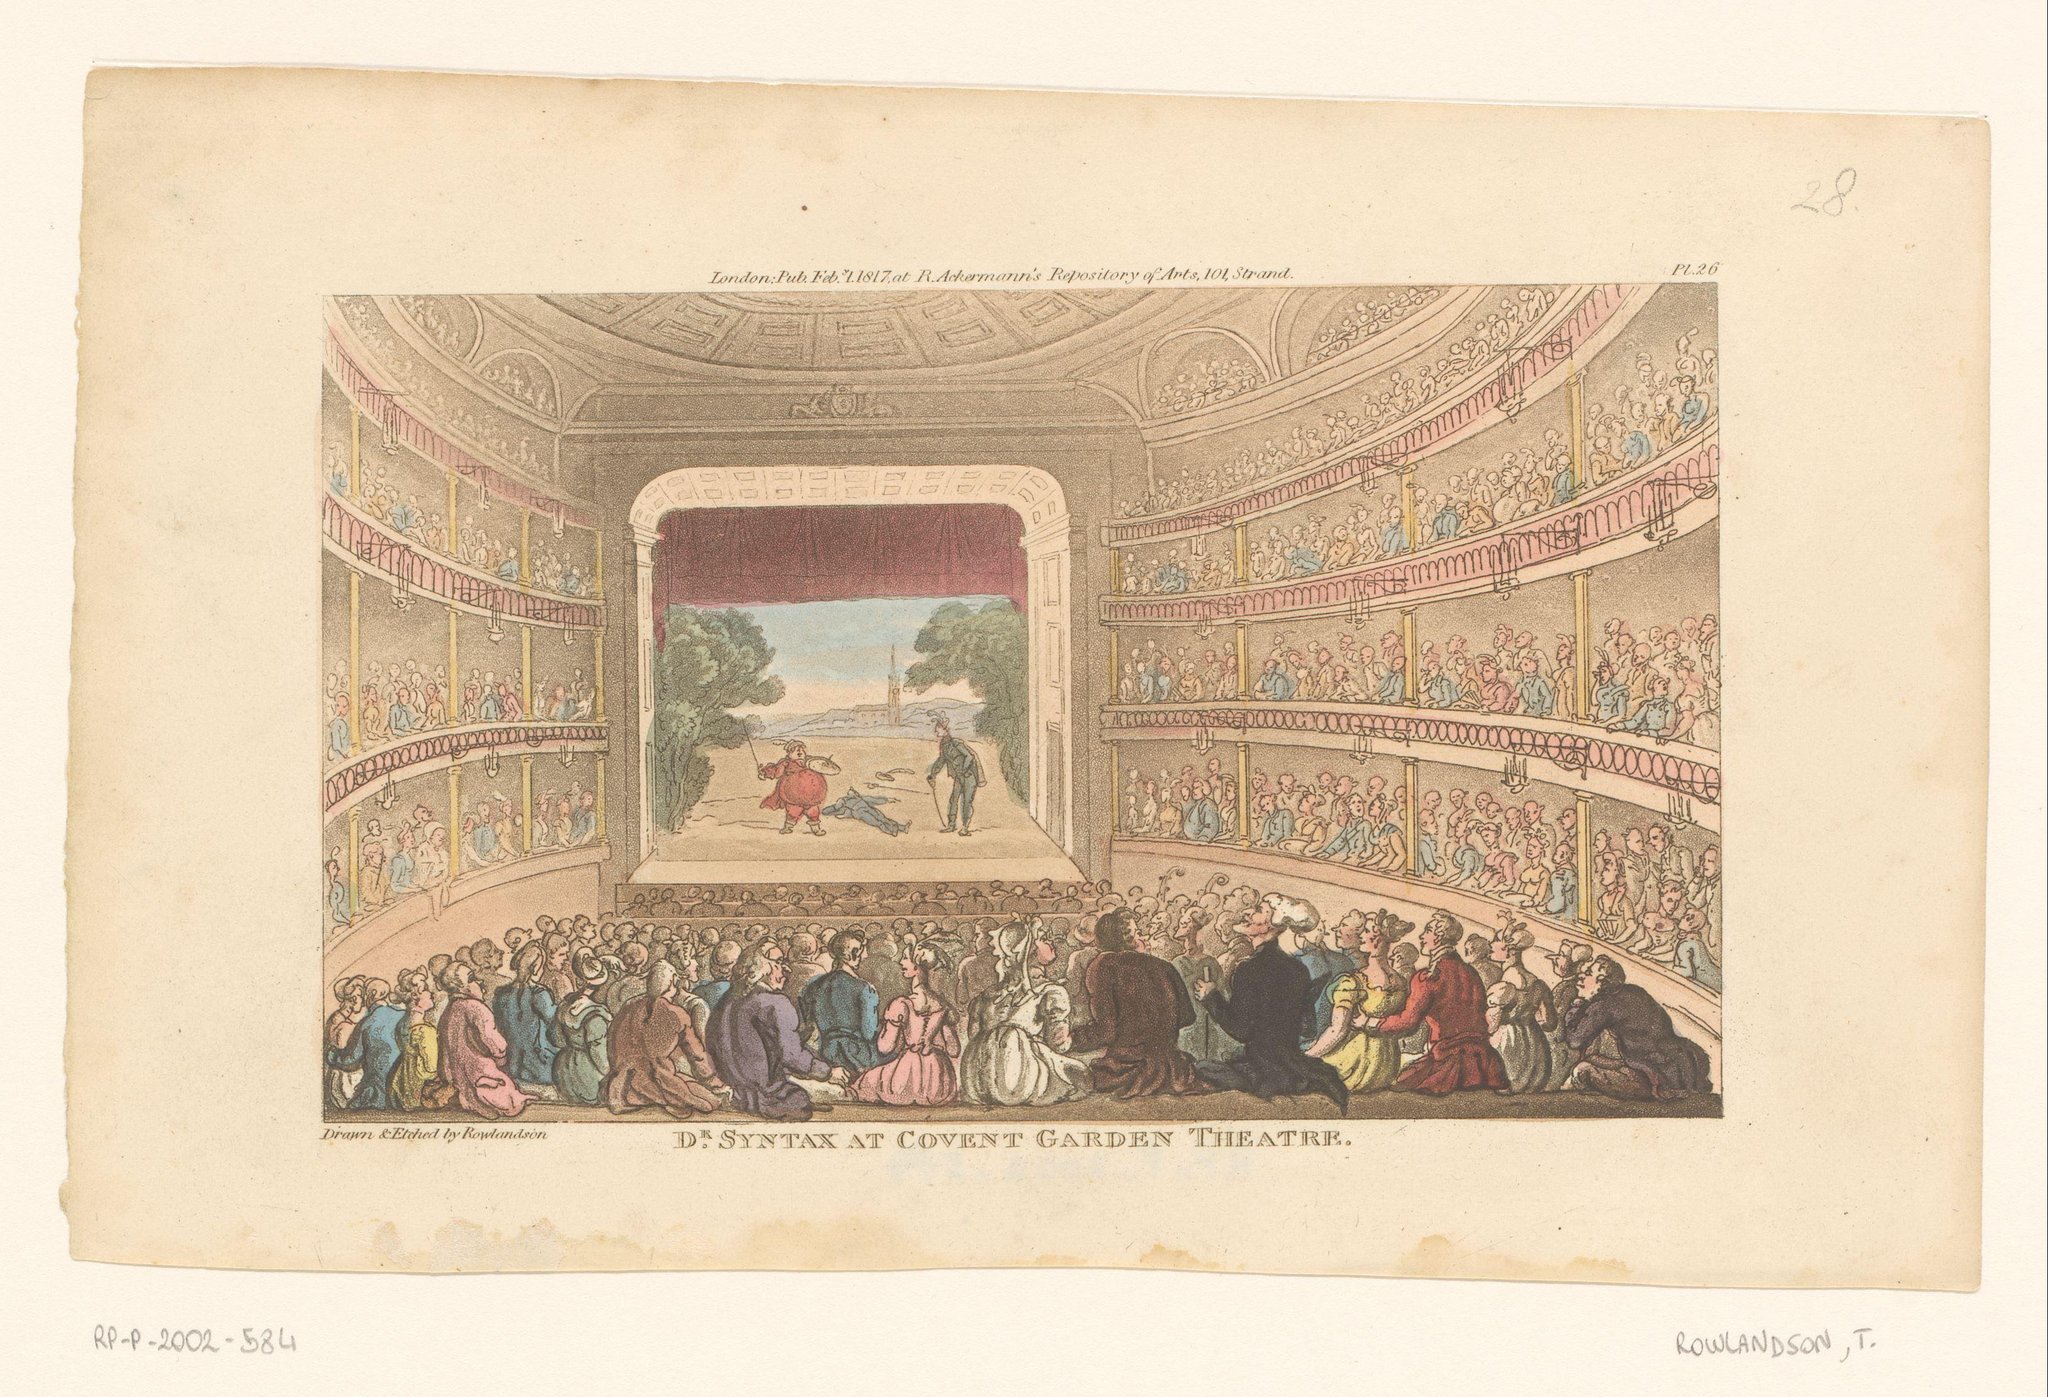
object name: print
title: Dr. Syntax at Covent Garden Theatre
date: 1802-1817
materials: paper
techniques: aquatint, etching, hand coloring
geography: london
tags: theatre, theatrical performance, theatre (building), the audience ~ art performance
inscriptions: collector's mark: Lugt 2228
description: Prent ook gebruikt in: Combe, William. The Tour of Doctor Syntax, in Search of the Picturesque. A Poem. Londen: Rudolph Ackermann, 1819. Het gedicht is een satire op William Gilpin, die in Groot-Brittannië op zoek ging naar 'het pittoreske'. Het gedicht verscheen voor het eerst met illustraties van Rowlandson in The Poetical Magazine, tussen 1809 en 1811. Voor de editie uit 1819 zijn nieuwe platen gemaakt.